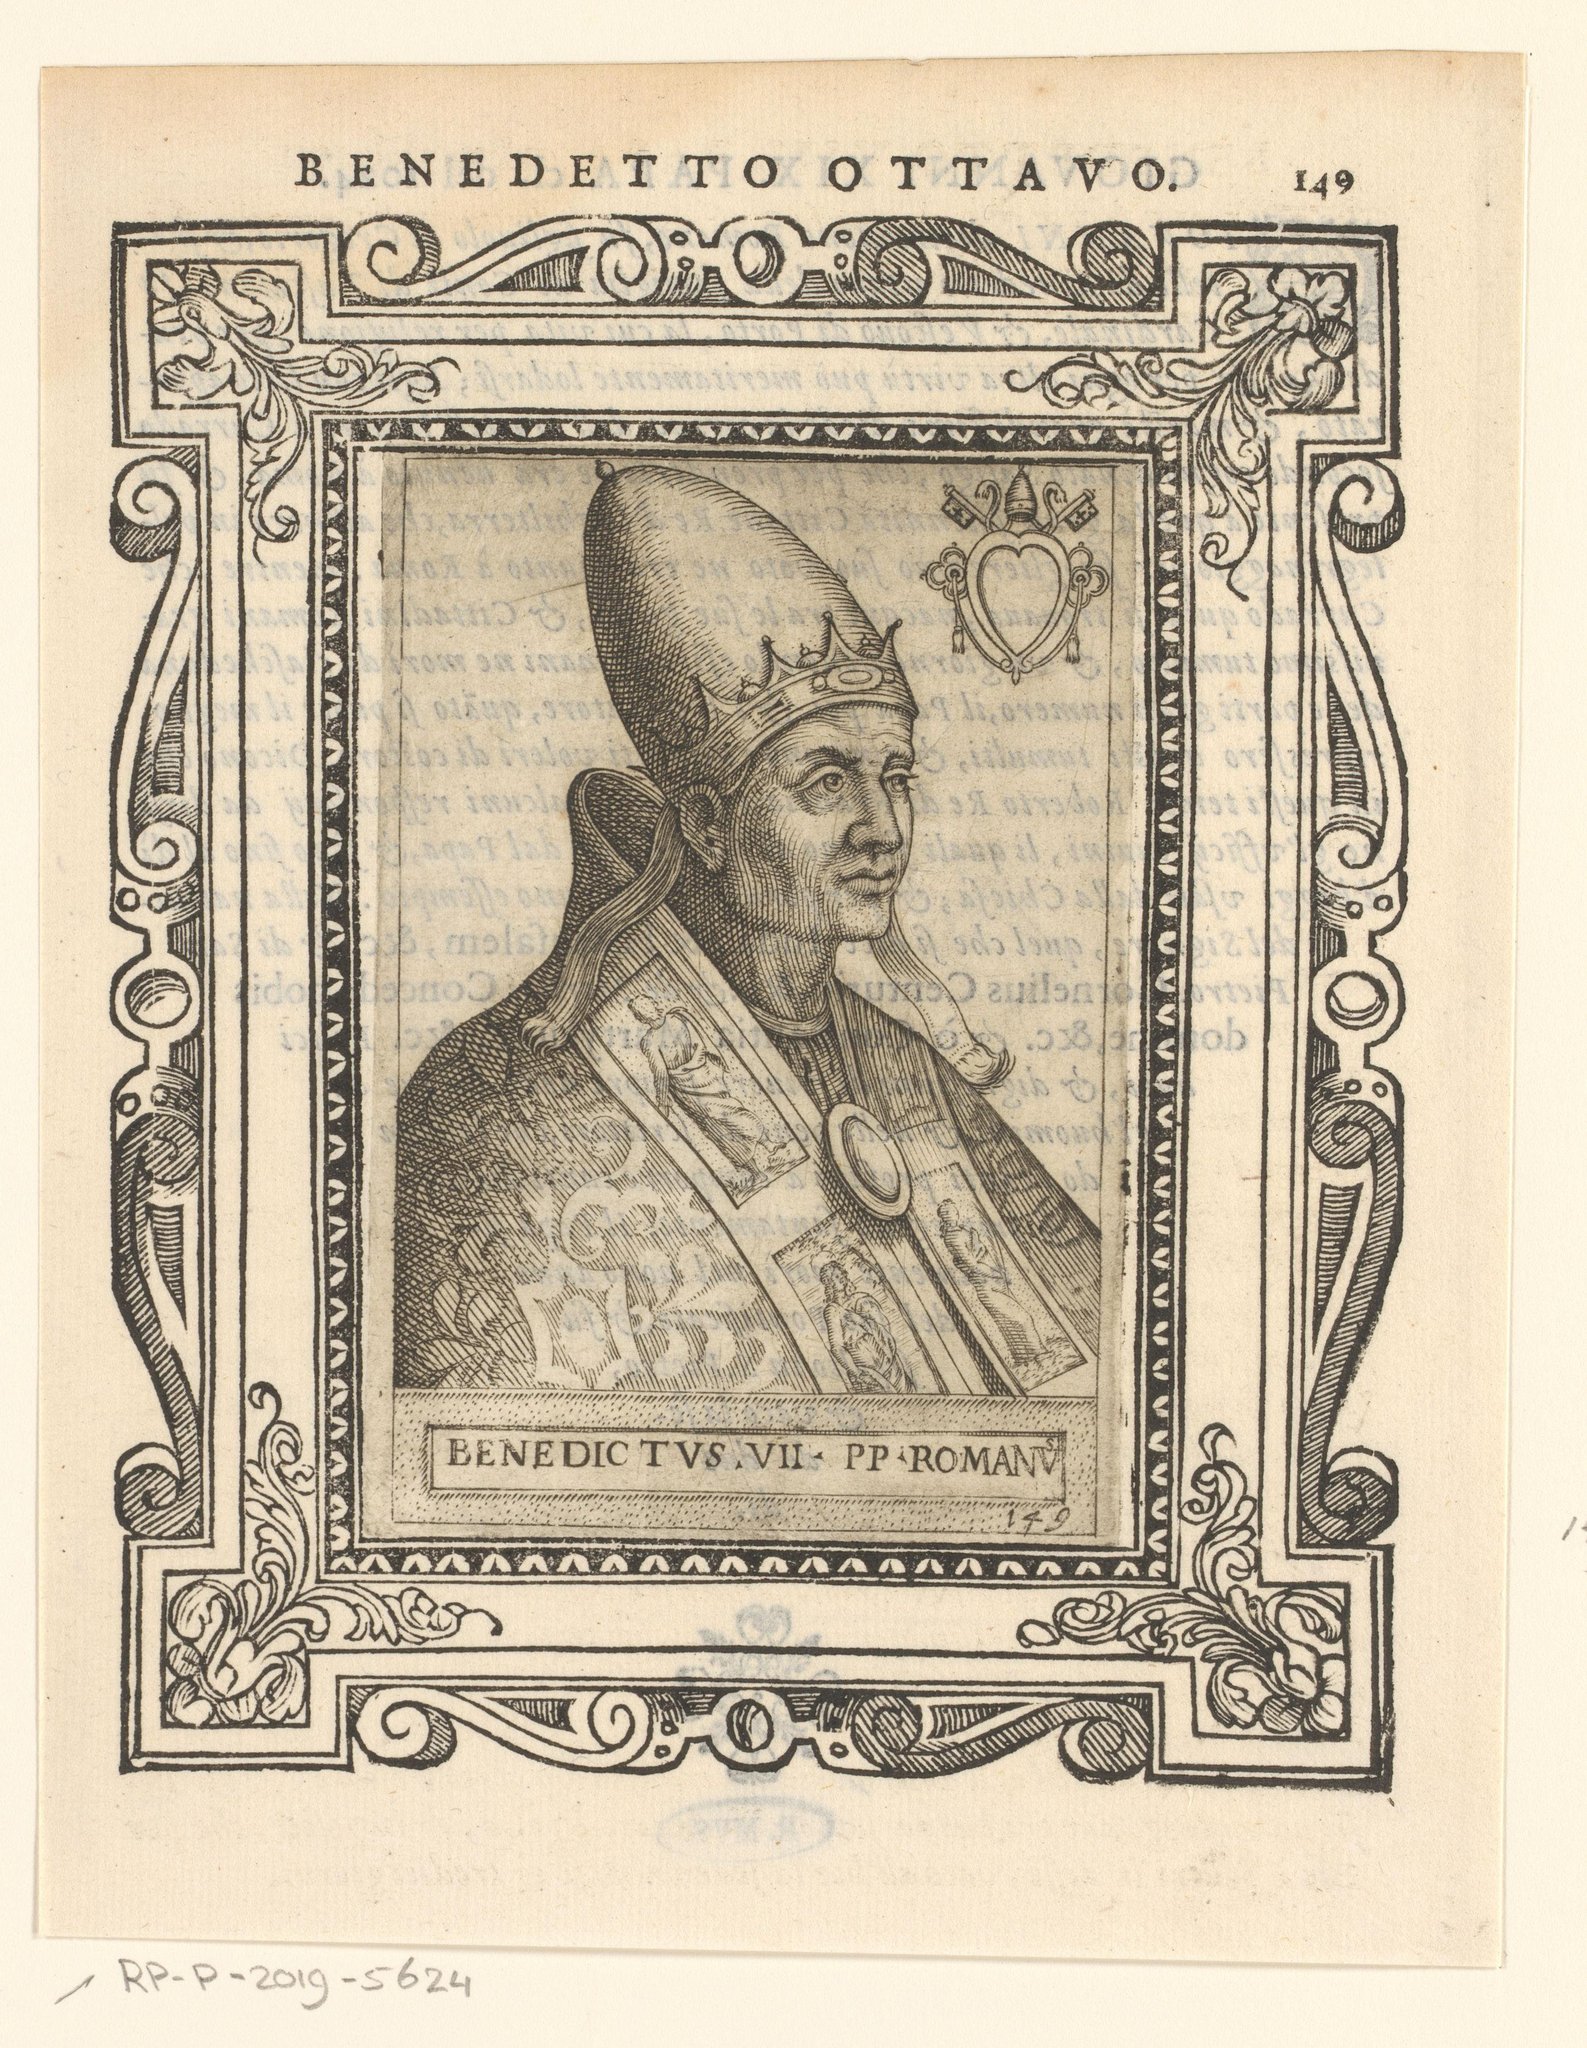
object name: print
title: Benedictus VII PP Romanus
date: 1587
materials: paper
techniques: engraving, letterpress printing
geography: rome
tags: historical persons, pope, armorial bearing, heraldry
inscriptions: collector's mark: Lugt 2228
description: Prent uit: Ciccarelli, Antonio. Le vite de Pontefici di Antonio Ciccarelli (...). Rome: Domenico Basa, 1587. Prent voor het eerst verschenen in: Cavalieri, Giovanni Battista de'. Pontificum romanorum effigies (...). Rome: Domenico Basa en Francesco Zanetti, 1580. Prent ook gebruikt in latere publicaties.